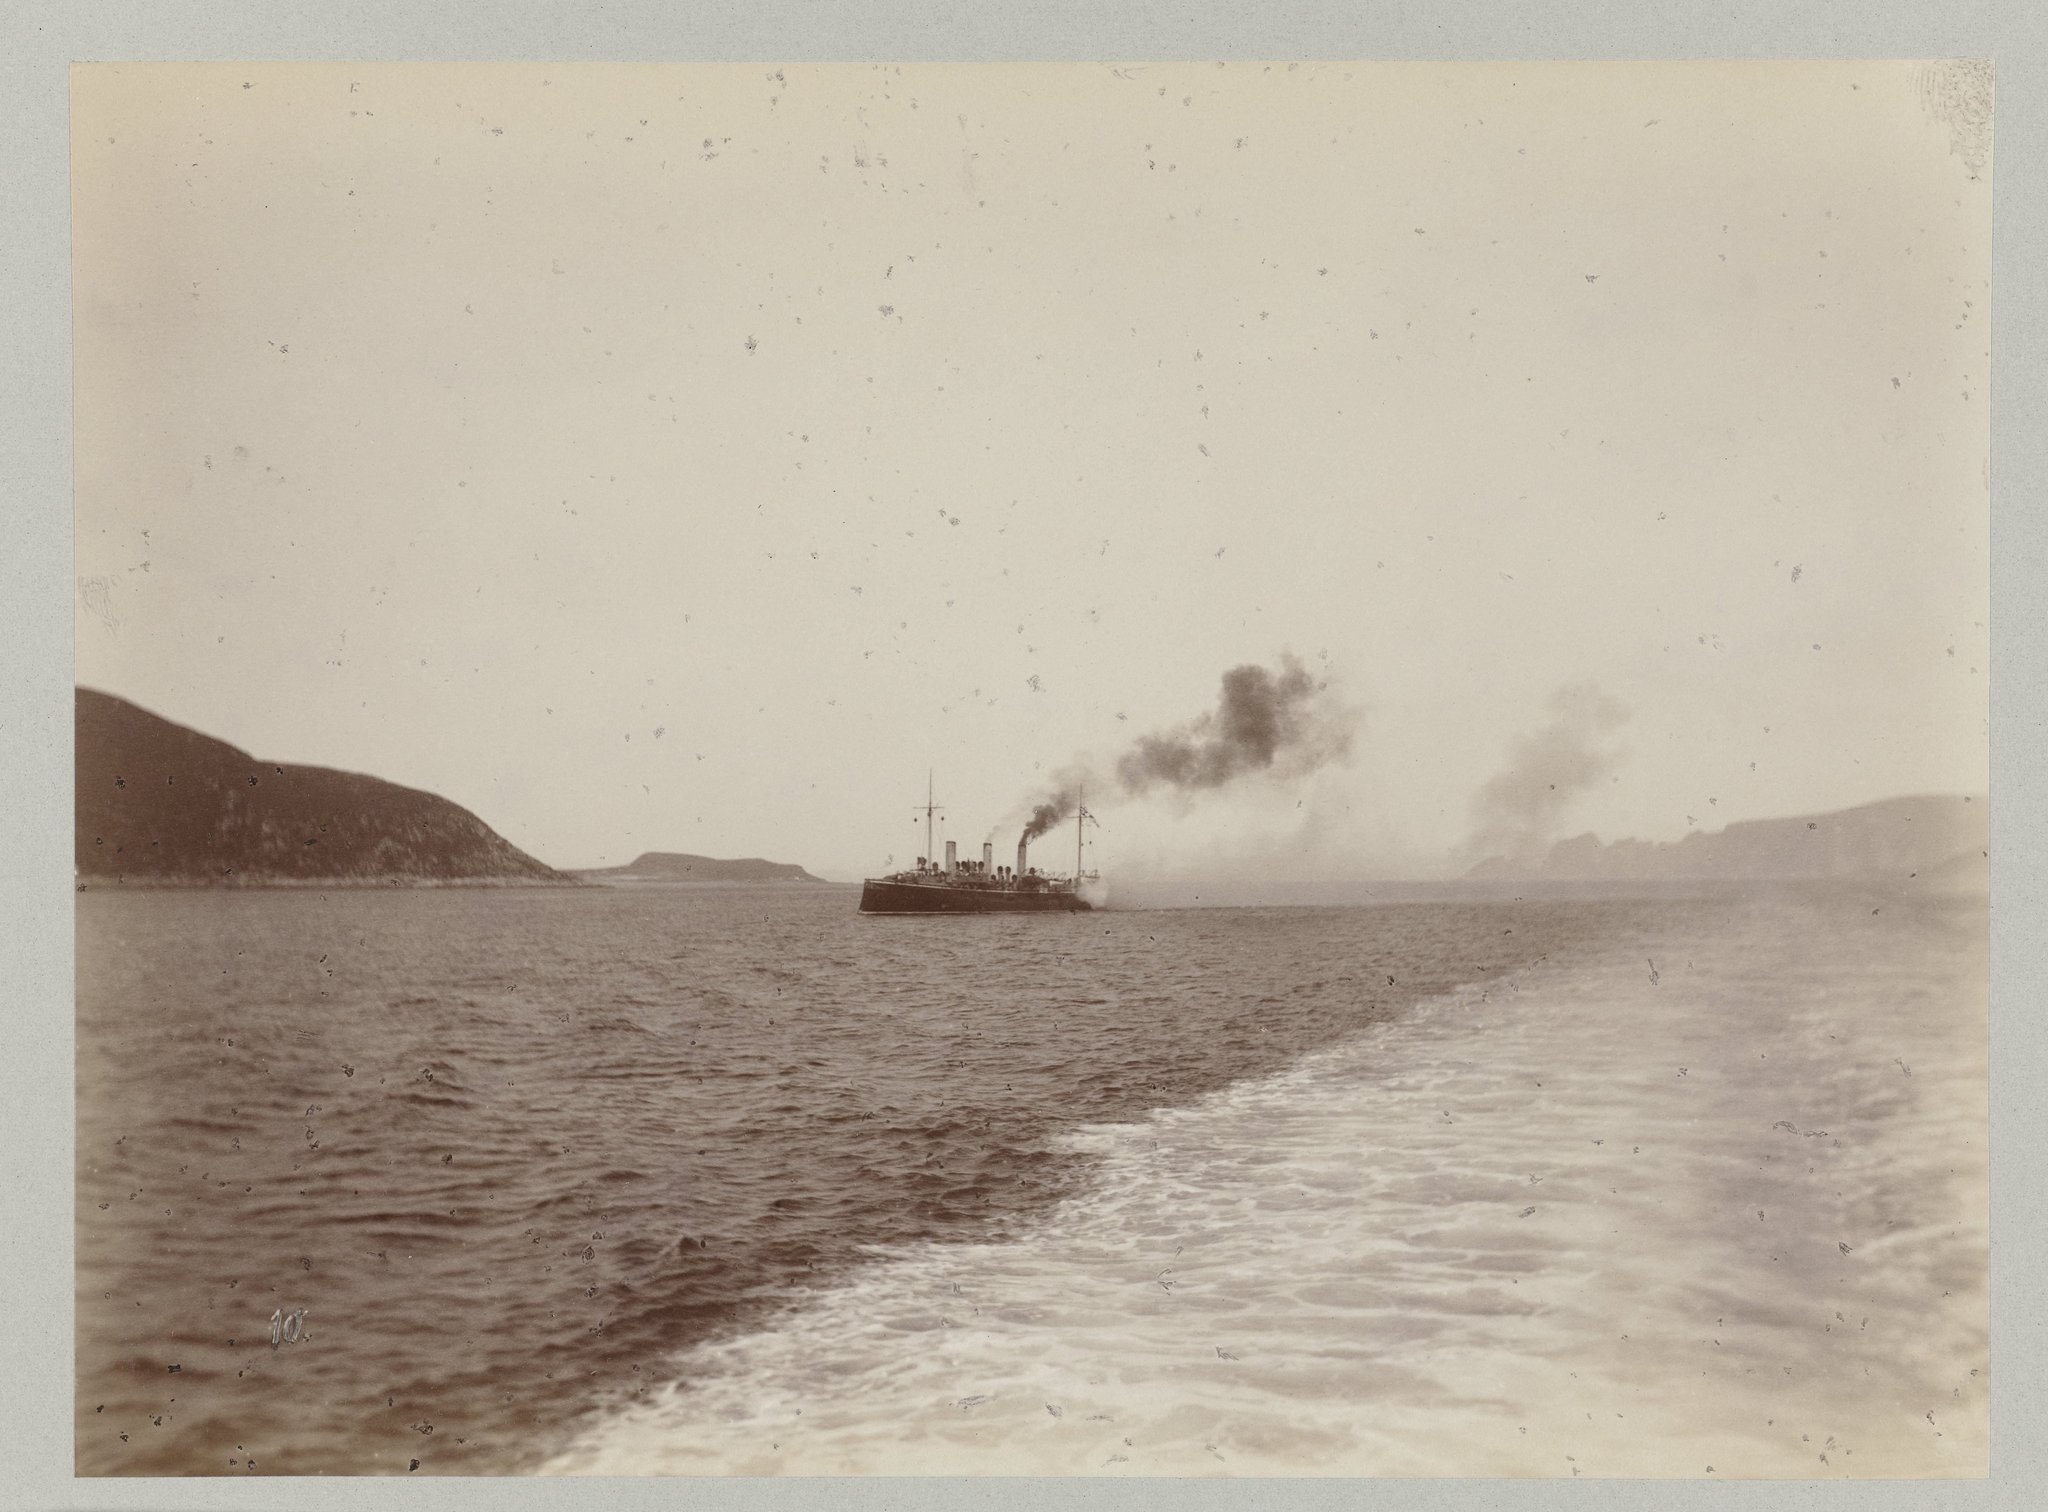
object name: photograph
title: Stoomschip op zee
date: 1807-1889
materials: cardboard, paper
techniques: albumen print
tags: wilhelm ii (keizer van duitsland), norway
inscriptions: number: ‘29’, number: ‘16’